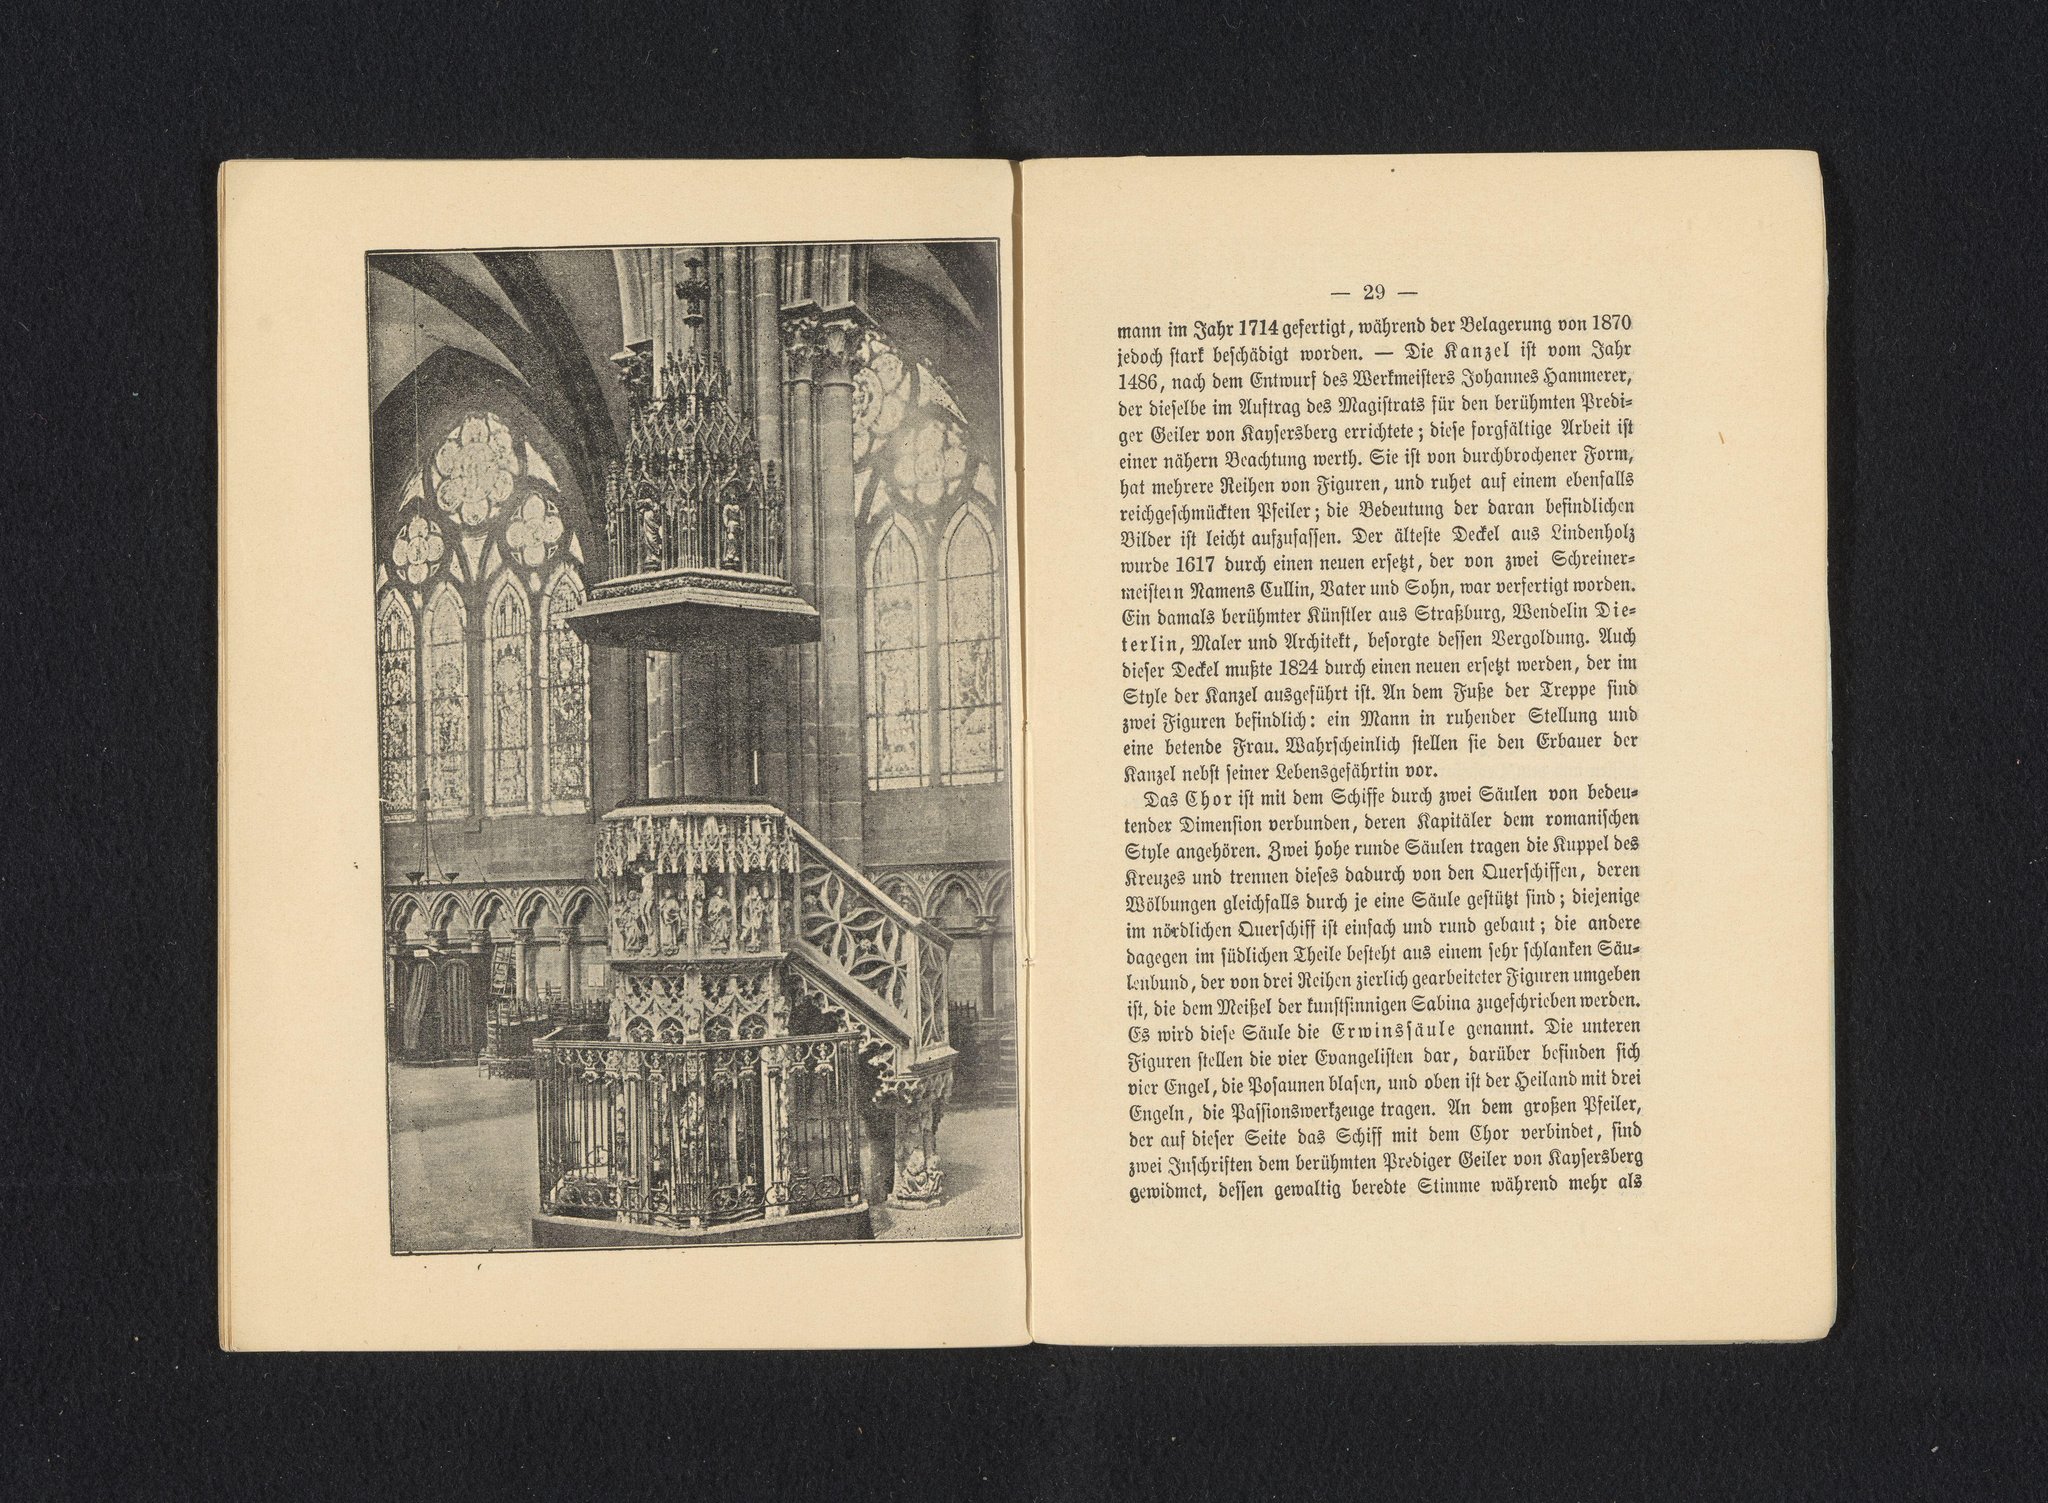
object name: photomechanical print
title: Gezicht op een preekstoel in de Kathedraal van Straatsburg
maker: Anonymous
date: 1897-1902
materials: paper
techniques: autotype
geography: straatsburg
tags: pulpit, ambo, chancel